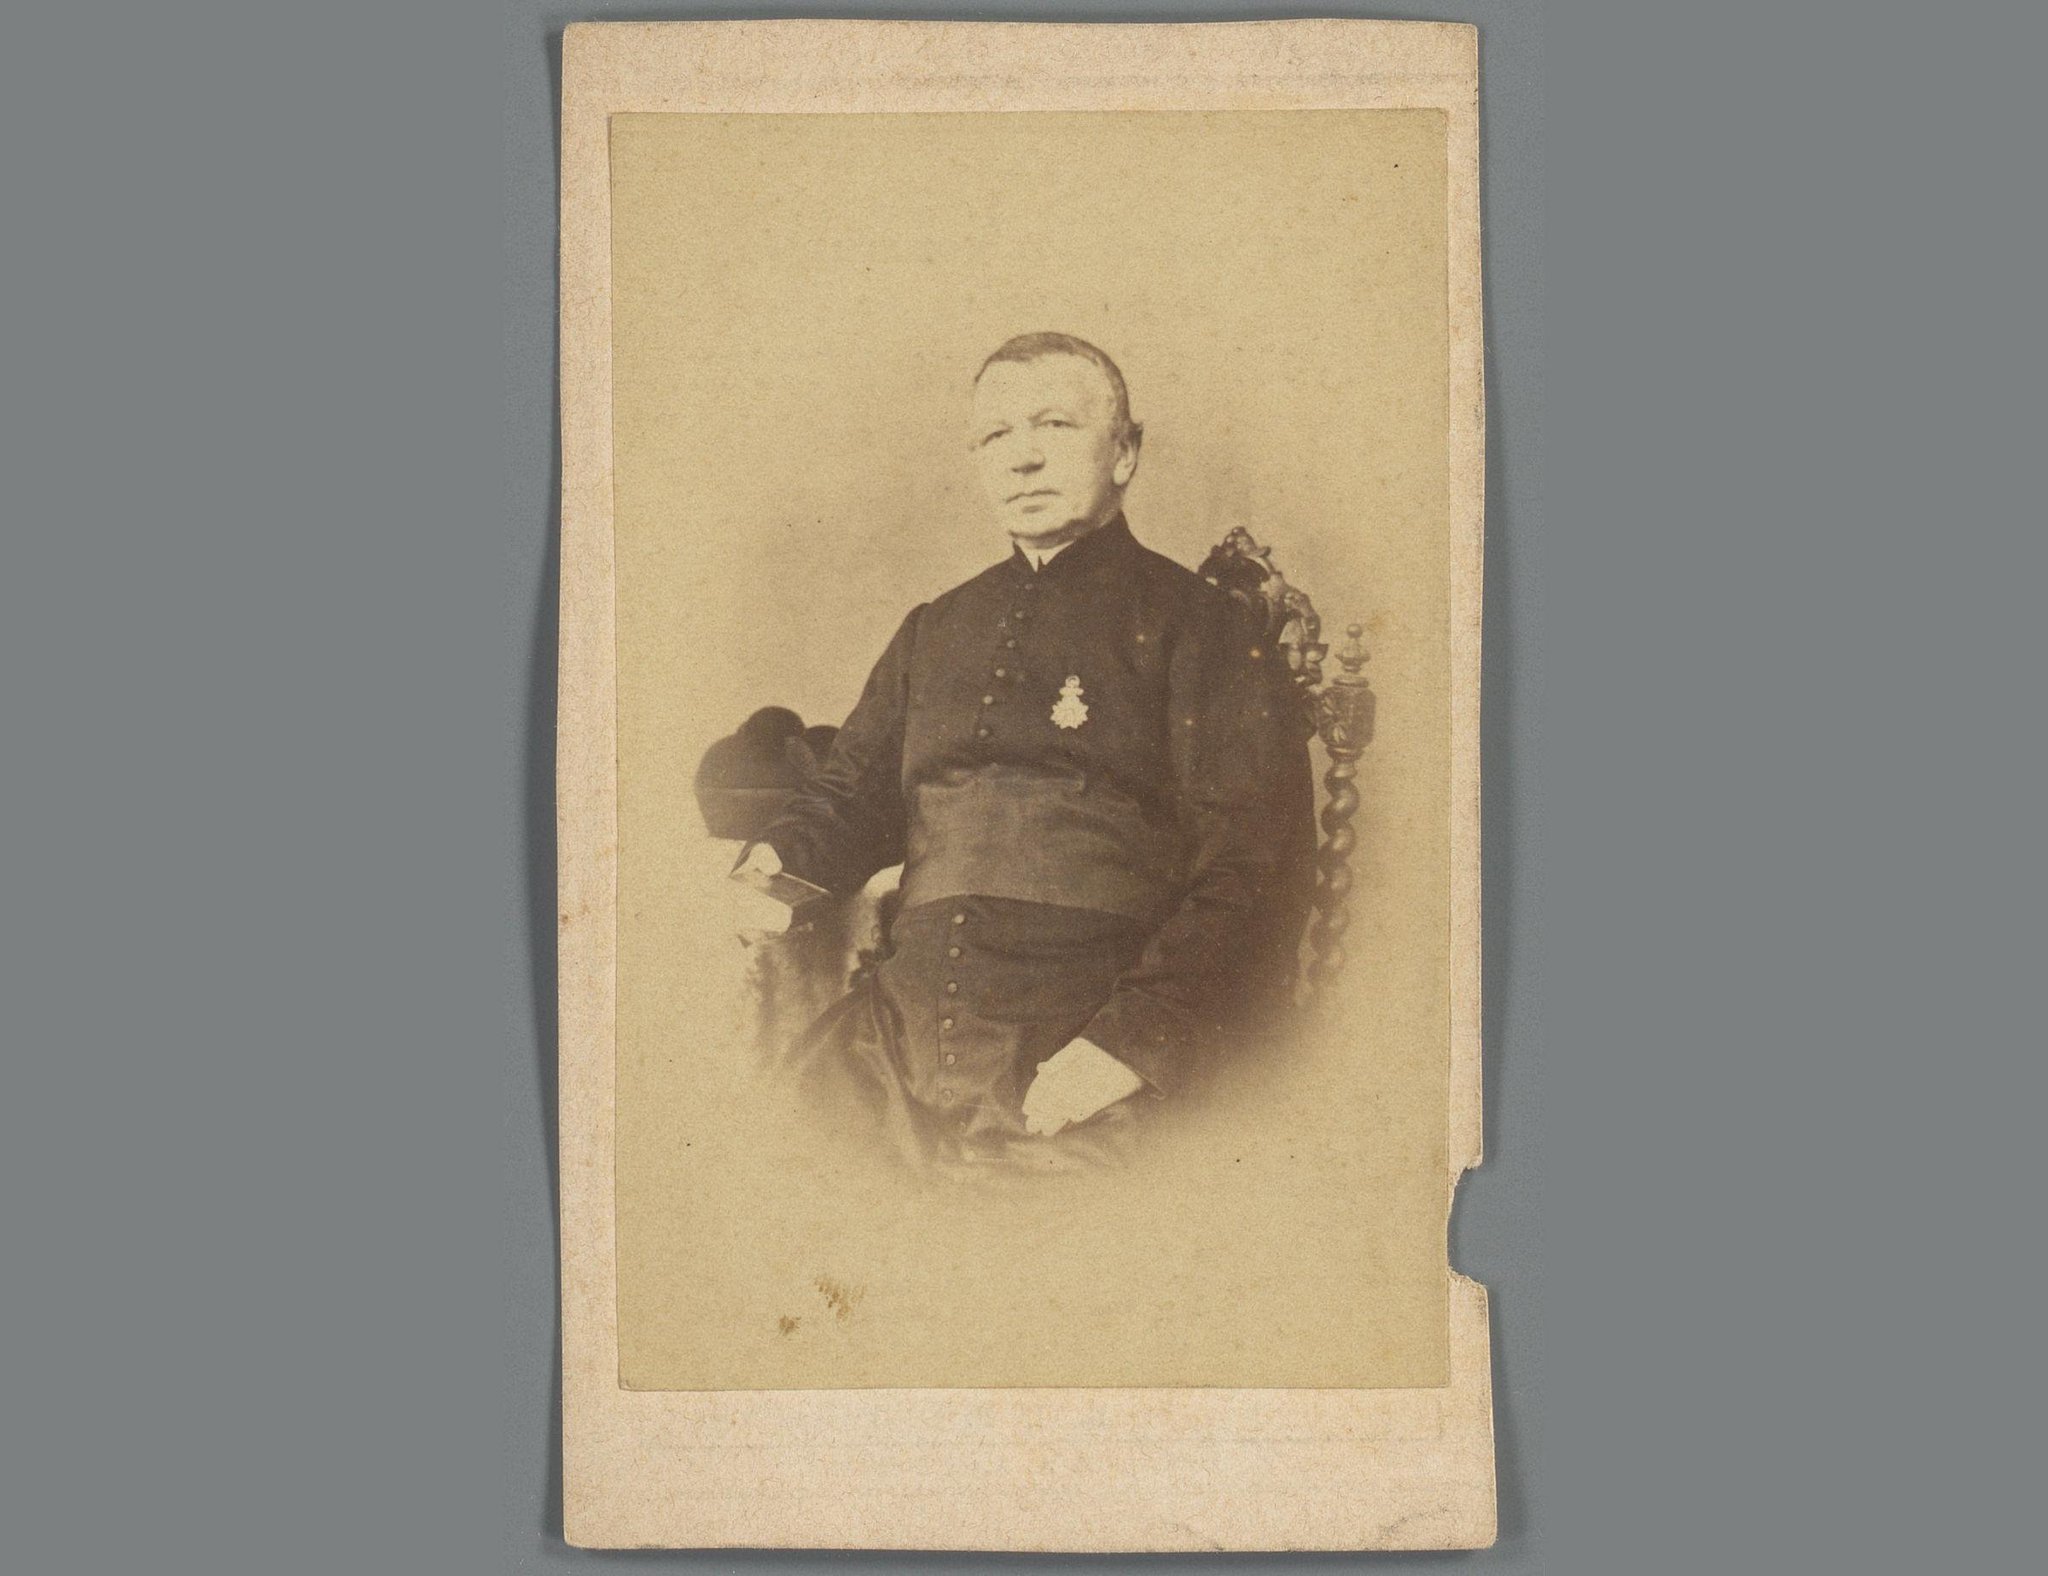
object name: prayer card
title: Portret van Antonius van den Heuvel op bidprent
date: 1864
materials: paper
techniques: albumen print, letterpress printing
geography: den bosch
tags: veghel, den bosch, priest (roman catholic), historical persons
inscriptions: inscription: ‘Bid voor de ziel van zaliger,/ den HoogEerwaardigen Heer/ Antonius van den Heuvel (...) R.I.P./ 's Bosch - J.A.A. Schoonens.’